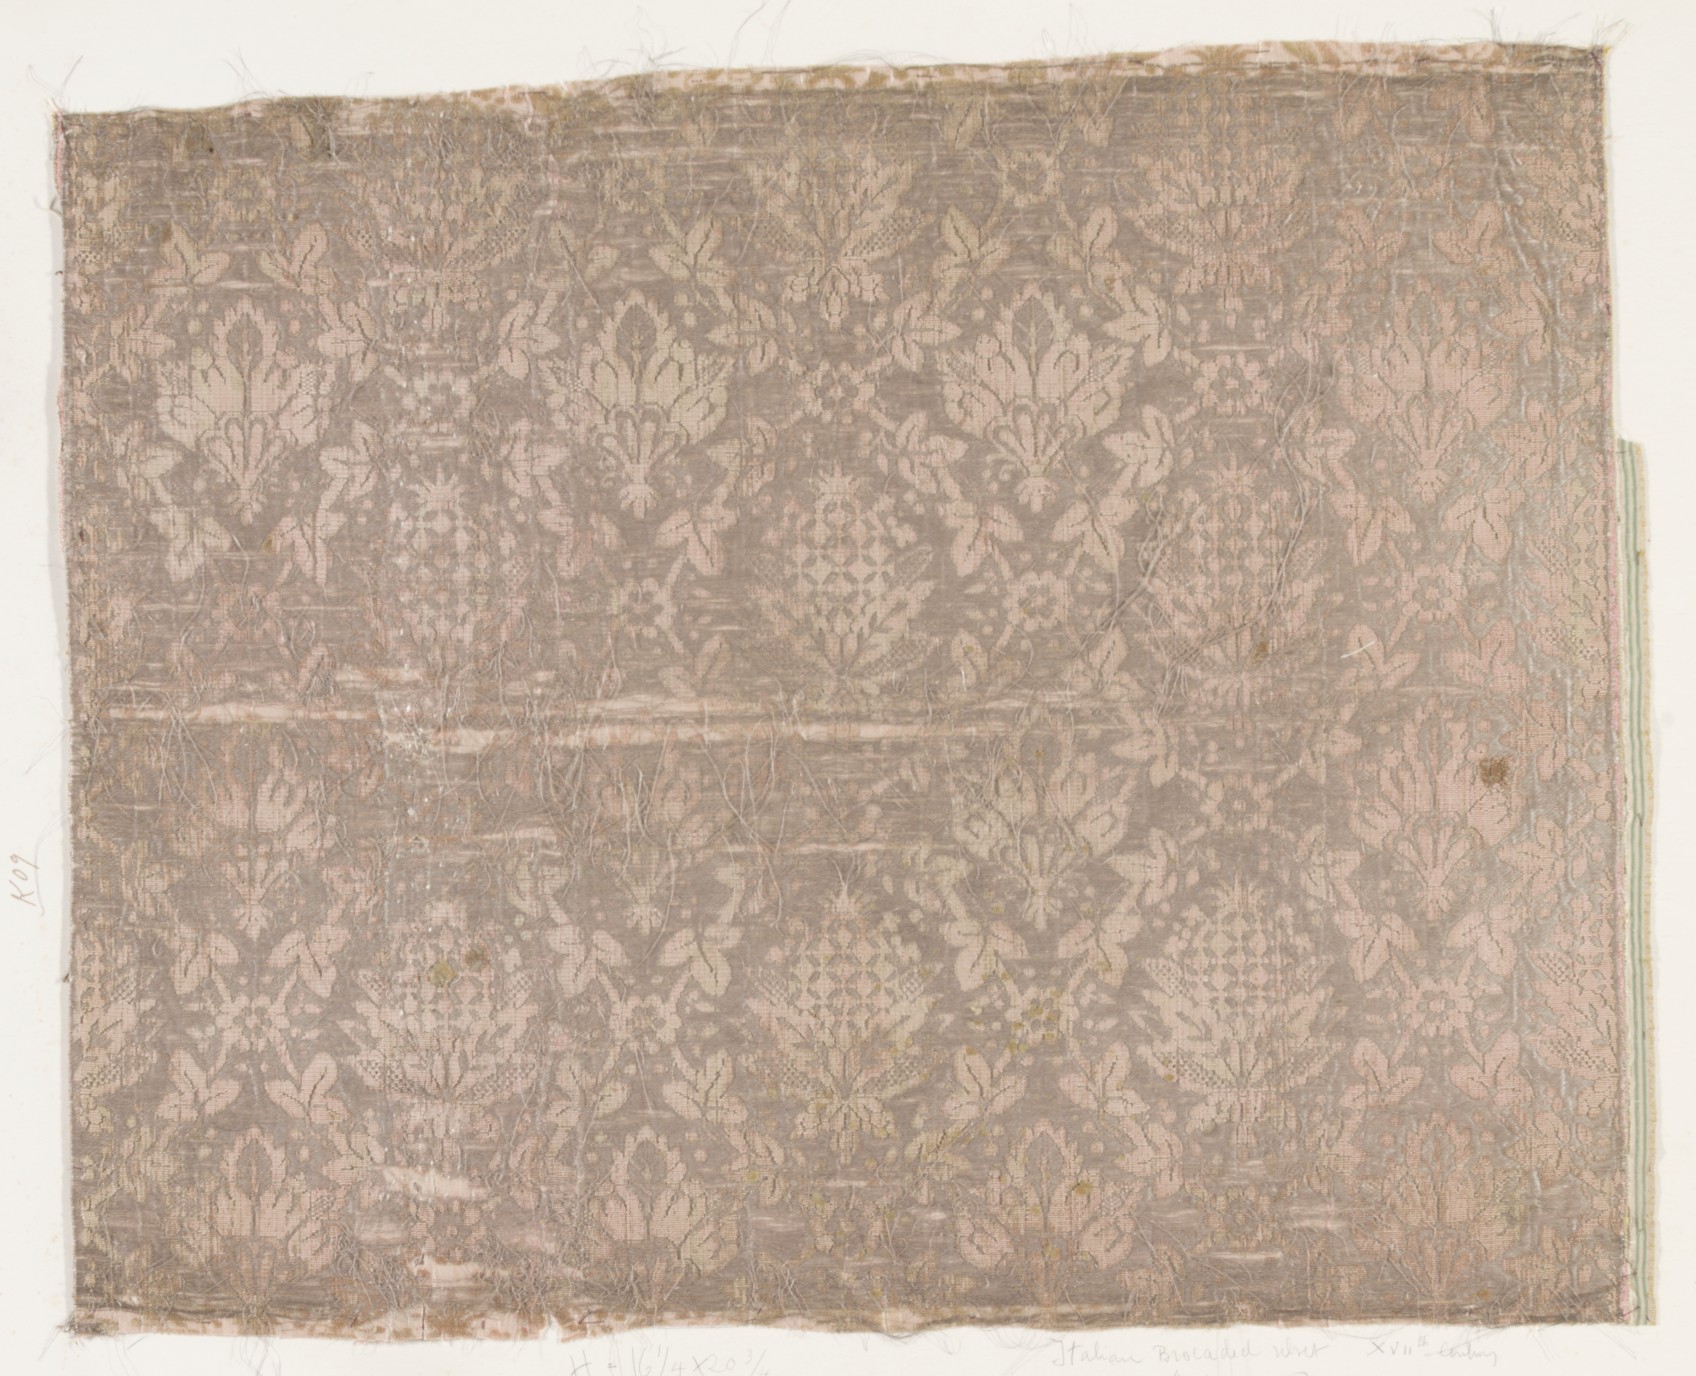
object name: fragment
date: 1601-1700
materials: metal thread, silk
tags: flowers